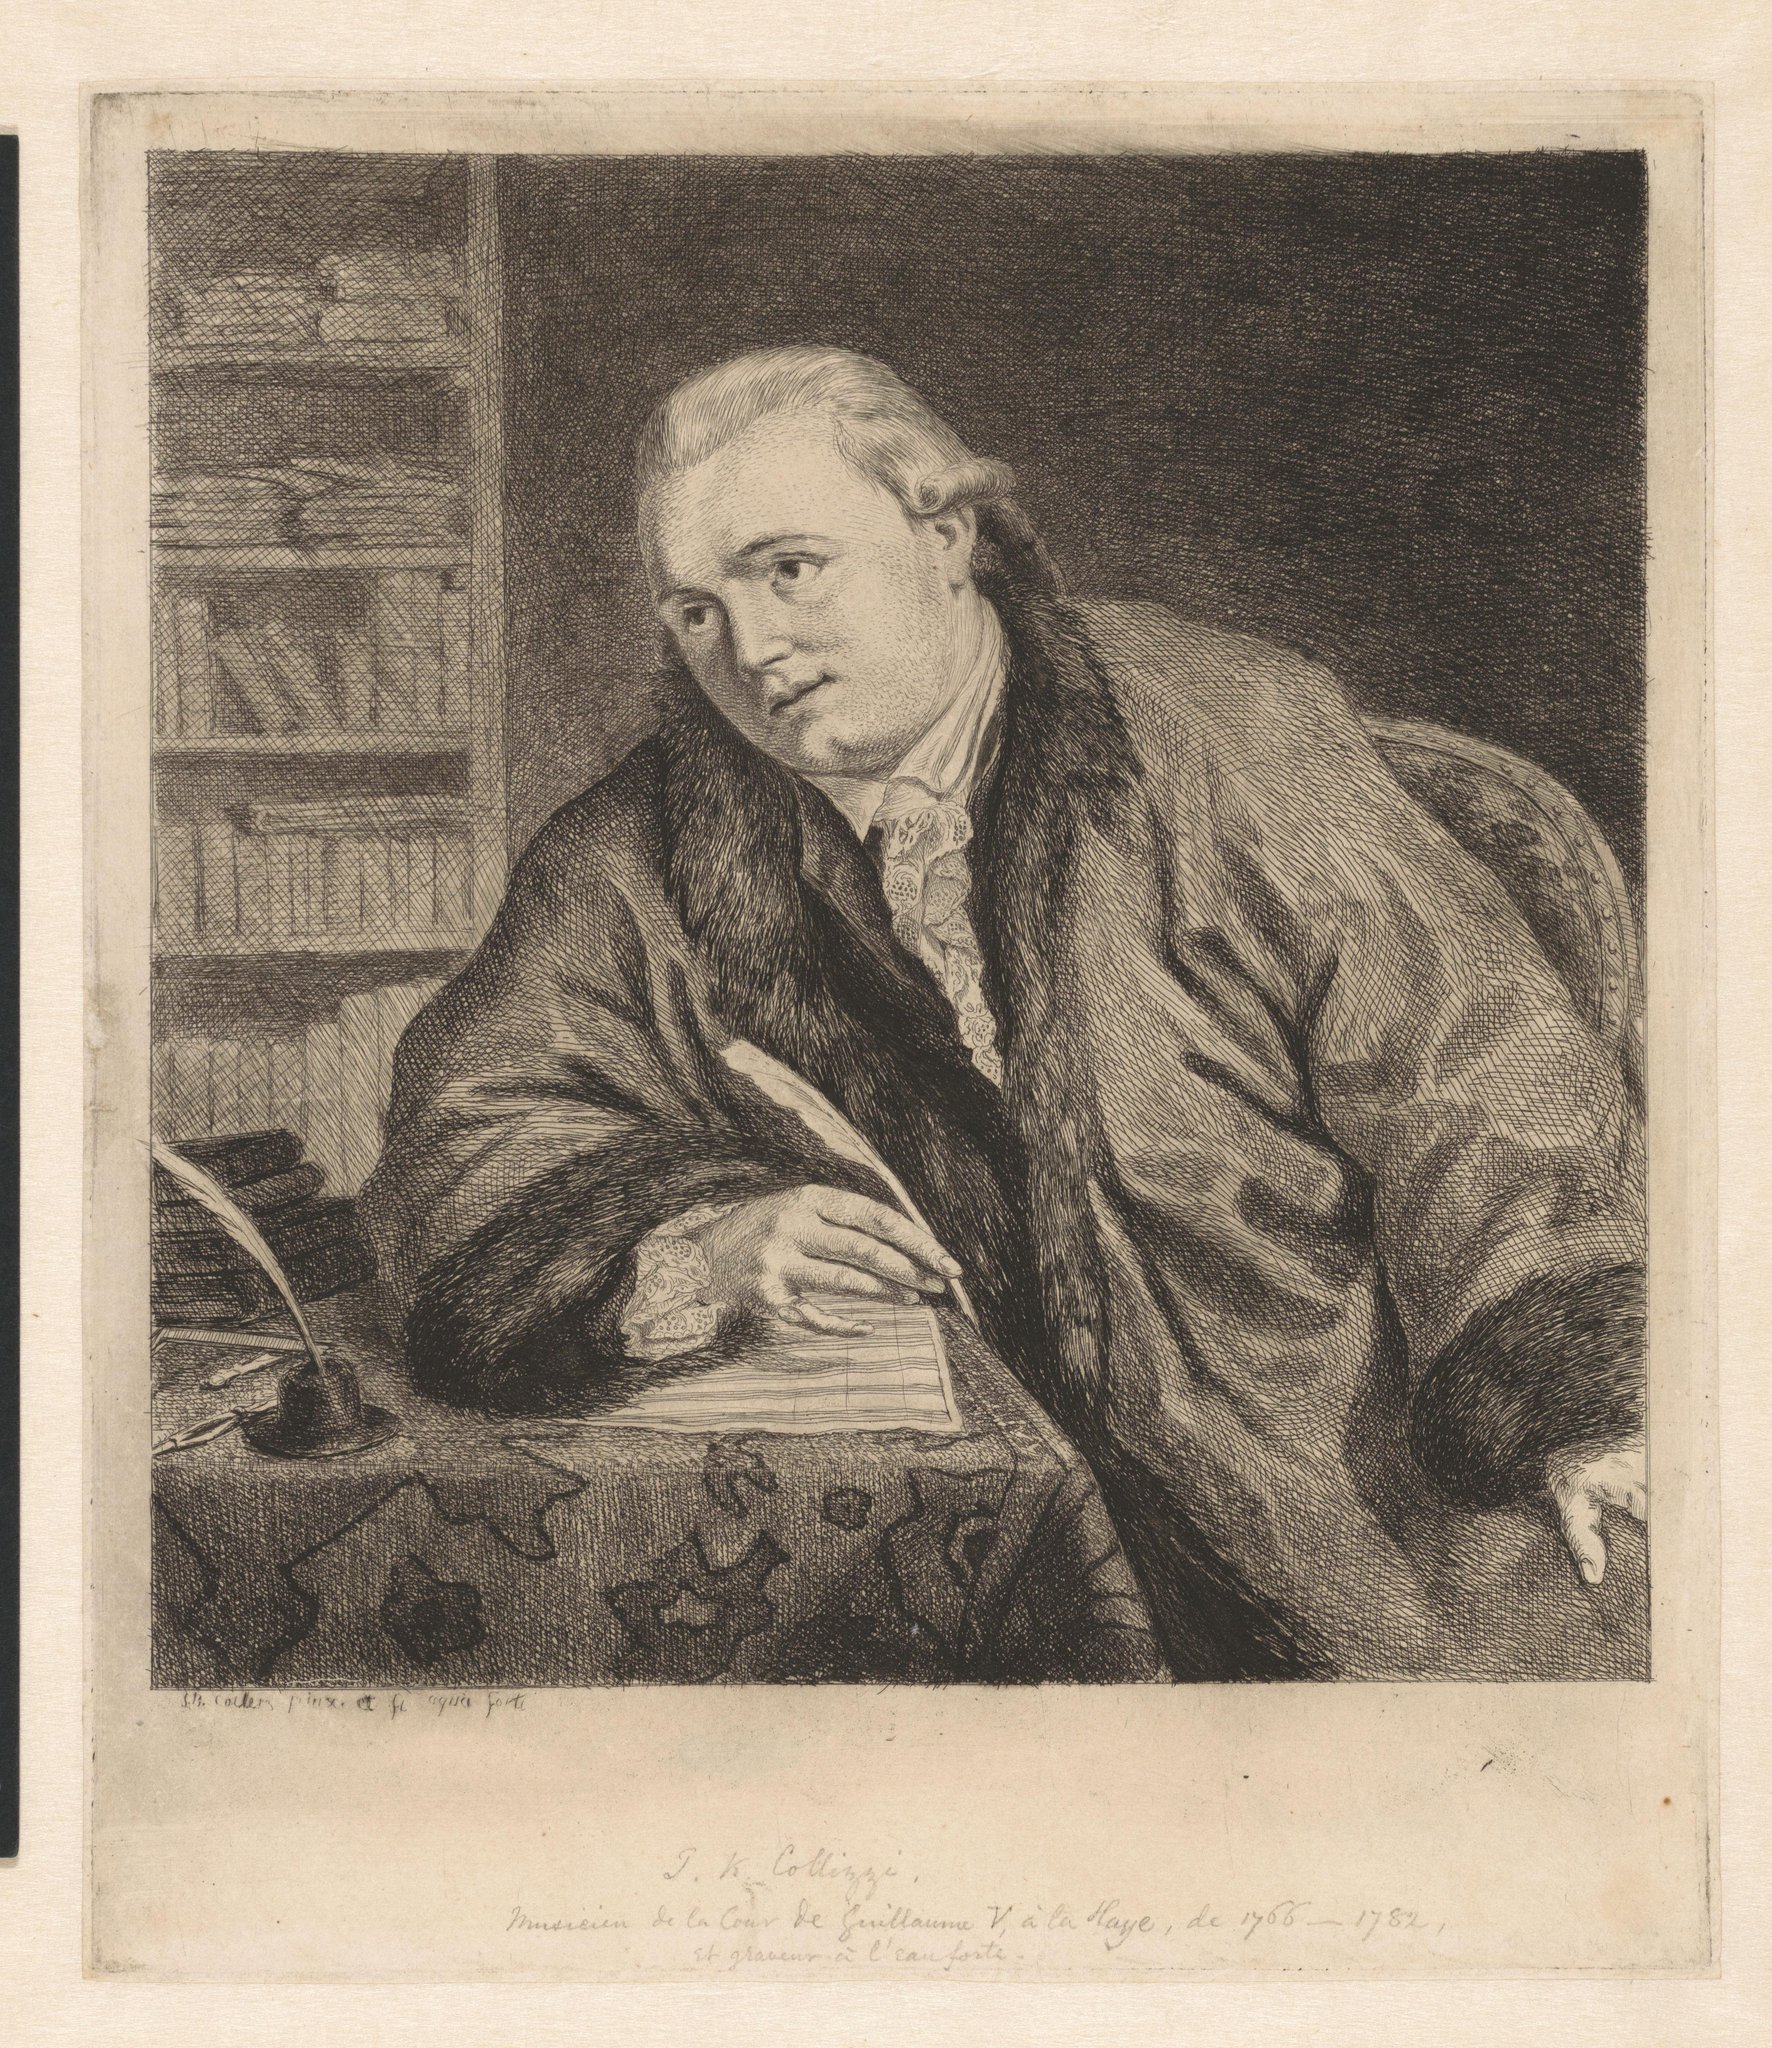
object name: print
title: Portret van de componist en etser Johan Antoni Kauclitz Colizzi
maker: louis bernard coclers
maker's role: draughtsman, print maker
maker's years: 1741-1817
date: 1777-1808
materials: paper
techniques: etching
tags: paris, politician, gaspard de coligny (ii), portrait, self-portrait of artist, writing and letters, composer at work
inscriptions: collector's mark: Lugt 2228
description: Johan Antoni Kauclitz Colizzi zittend aan tafel met een schrijfveer in zijn hand. Op tafel een aantal boeken, een inktpot en een blad papier. Colizzi draagt een ochtendjas die met bont is afgewerkt.